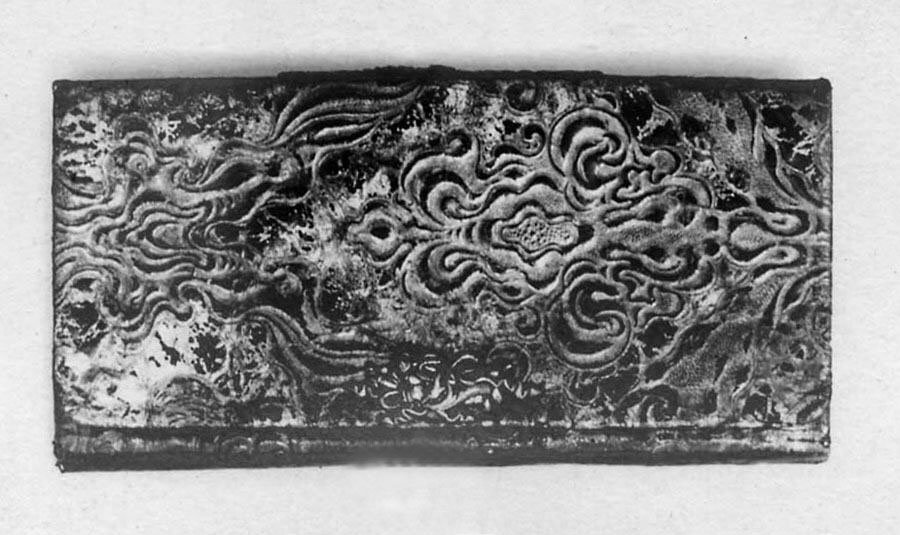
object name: pocket book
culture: japanese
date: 1801-1900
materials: gilt bronze, leather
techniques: stamping